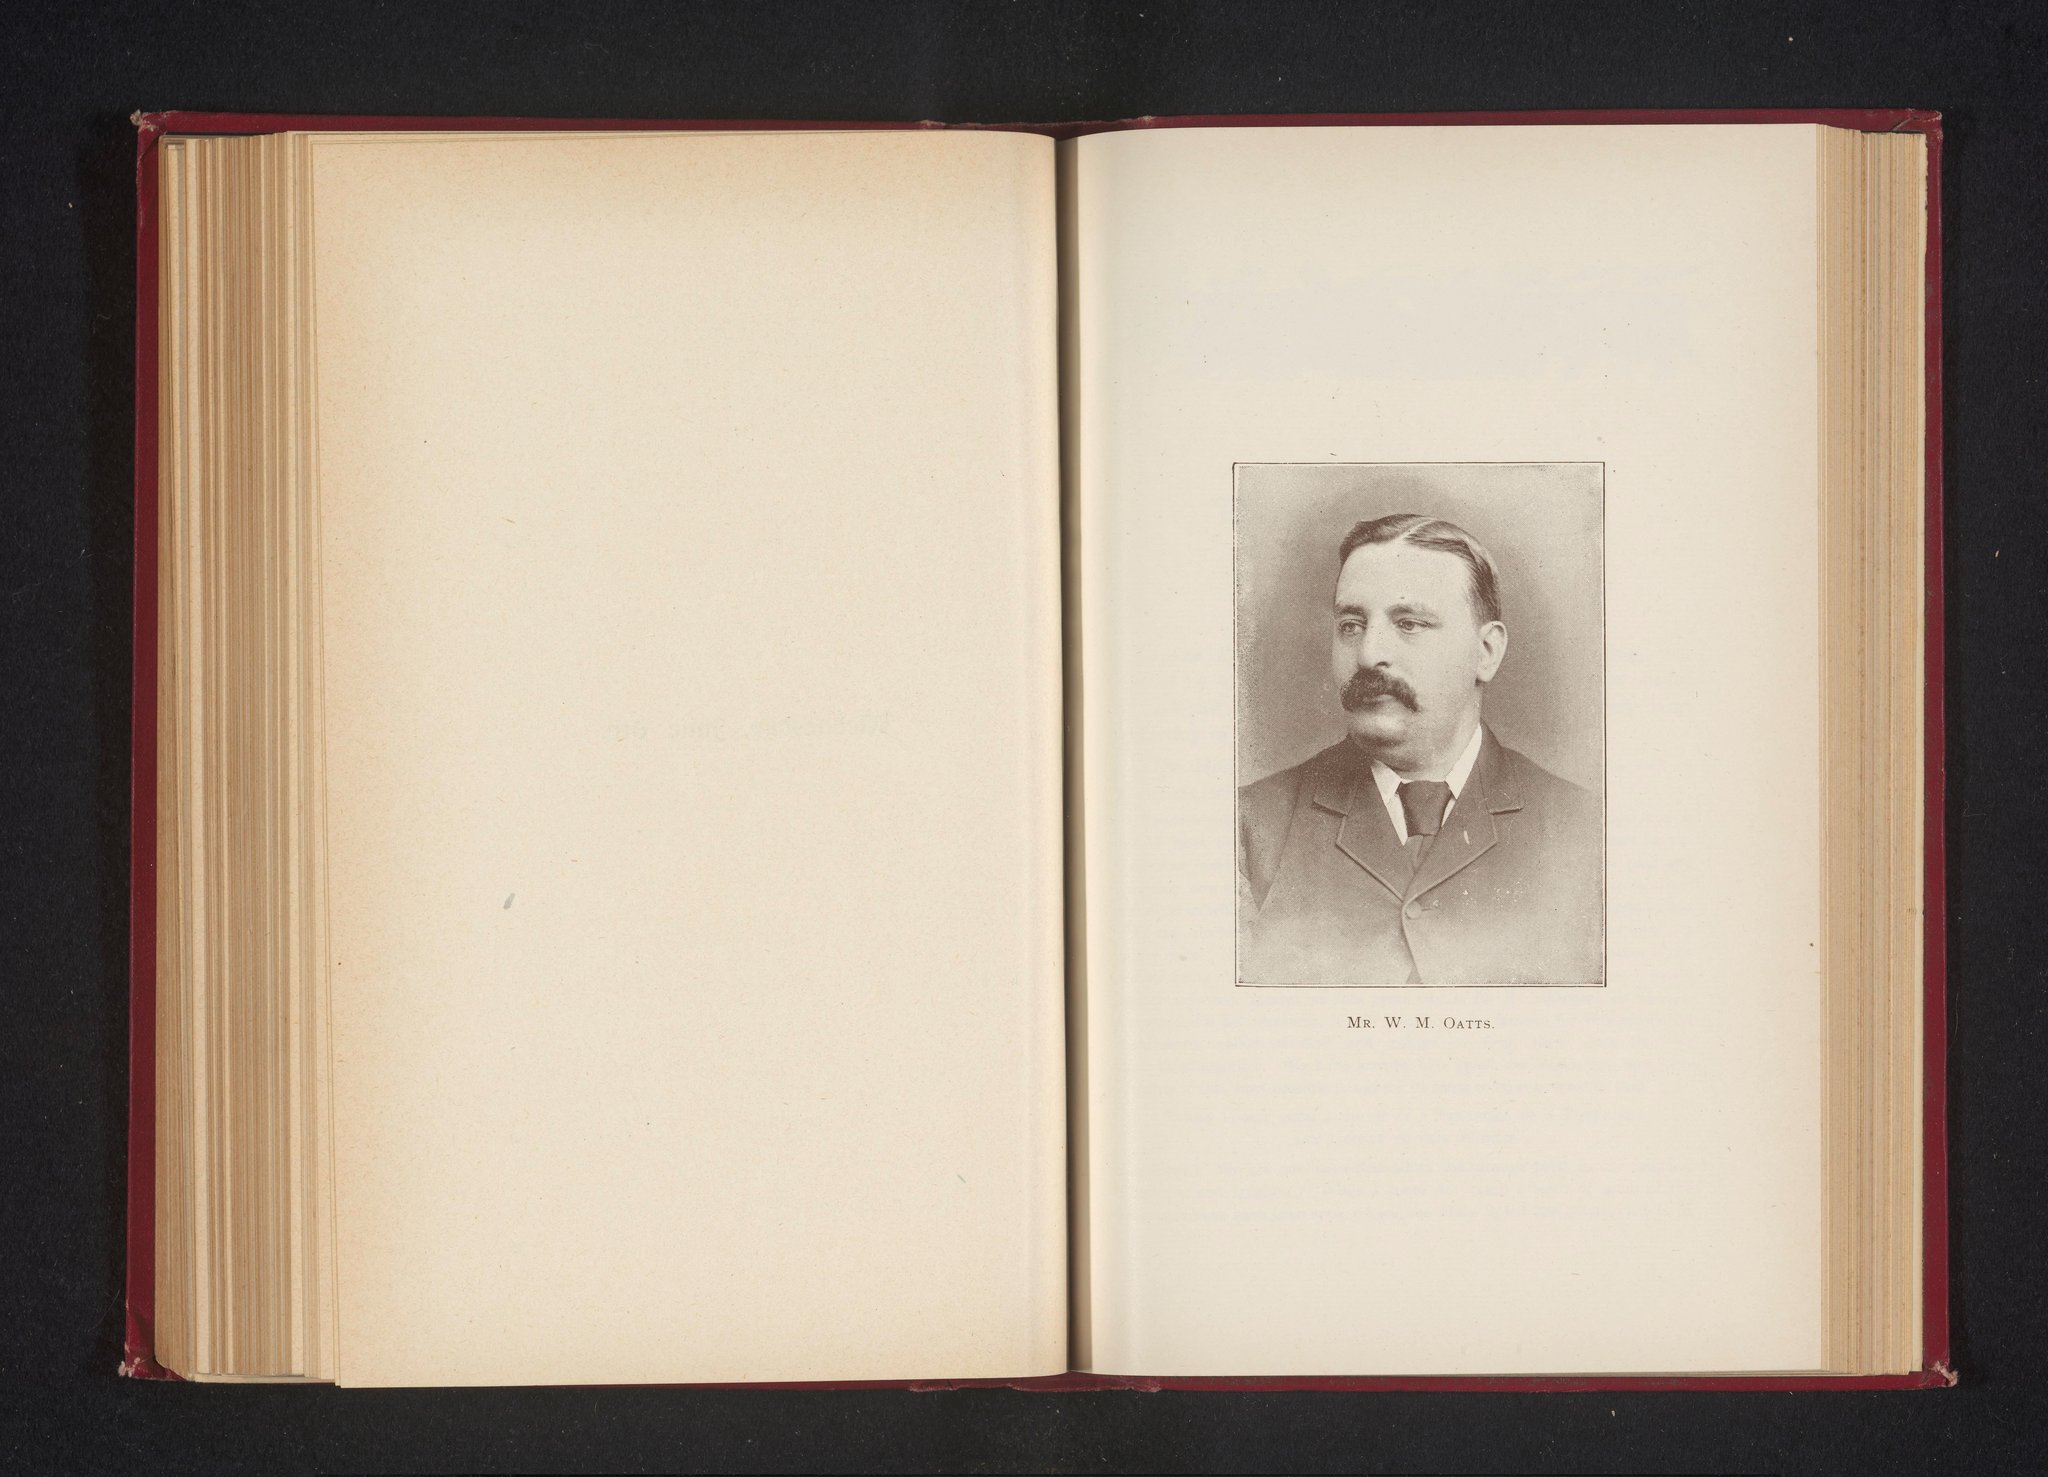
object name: photomechanical print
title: Mr. W. M. Oatts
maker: Anonymous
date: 1890-1895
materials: paper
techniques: autotype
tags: historical persons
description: Prent op vierde ongenummerde pagina na pagina 223.